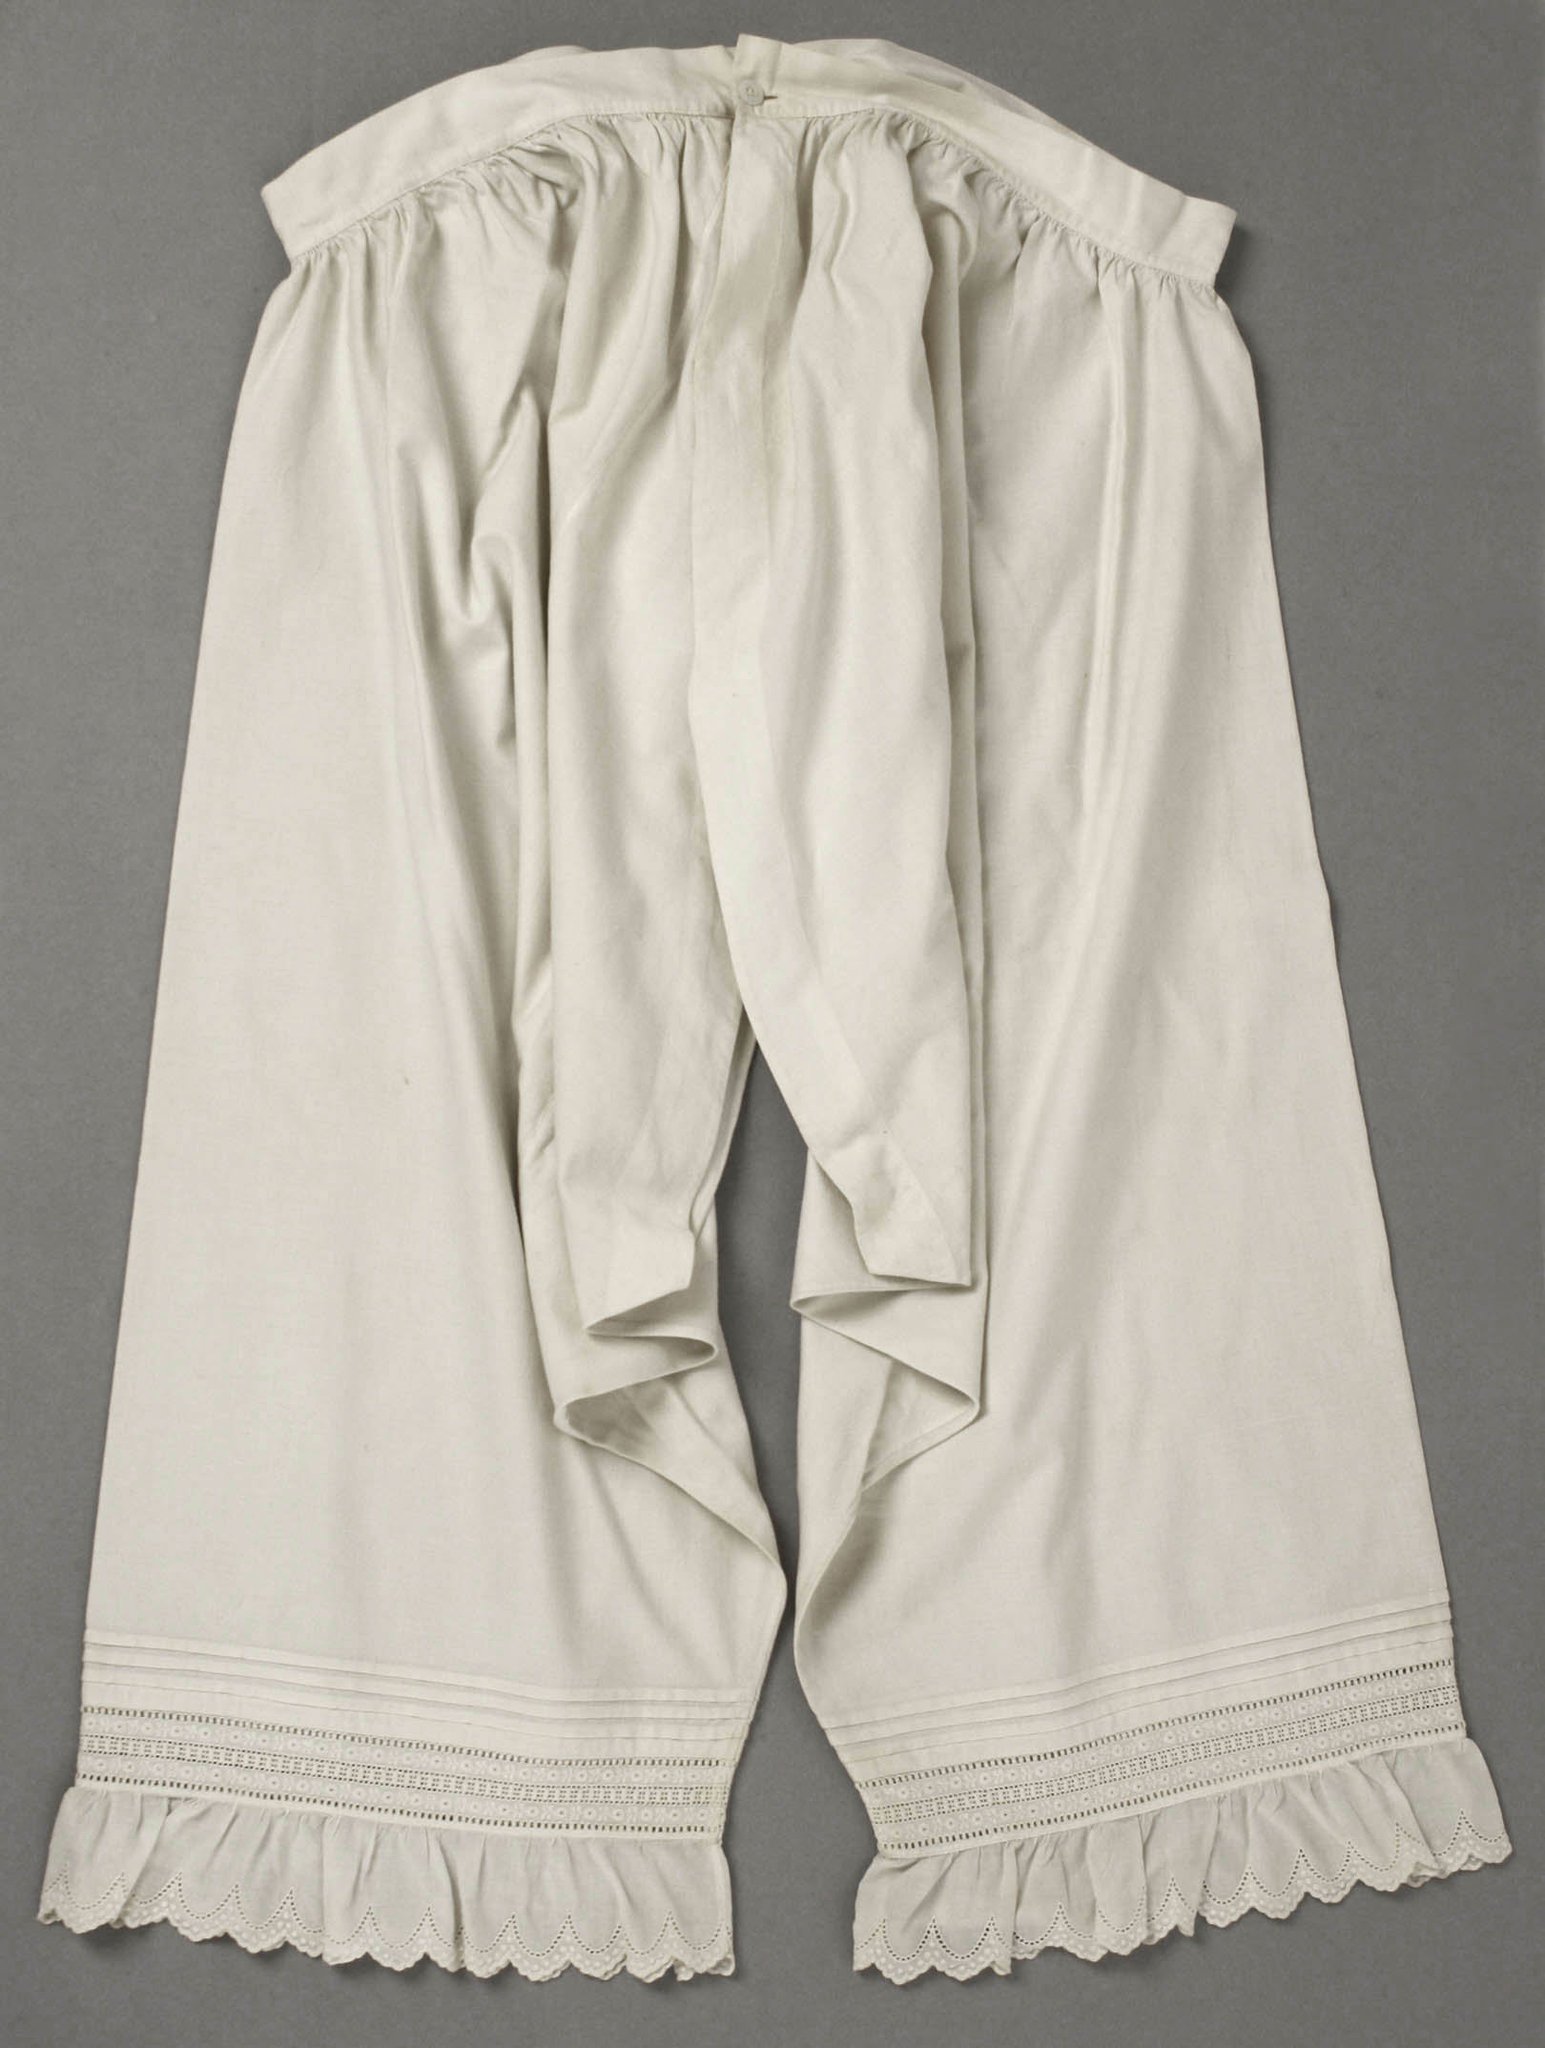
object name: drawer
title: Drawers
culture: american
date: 1860-1869